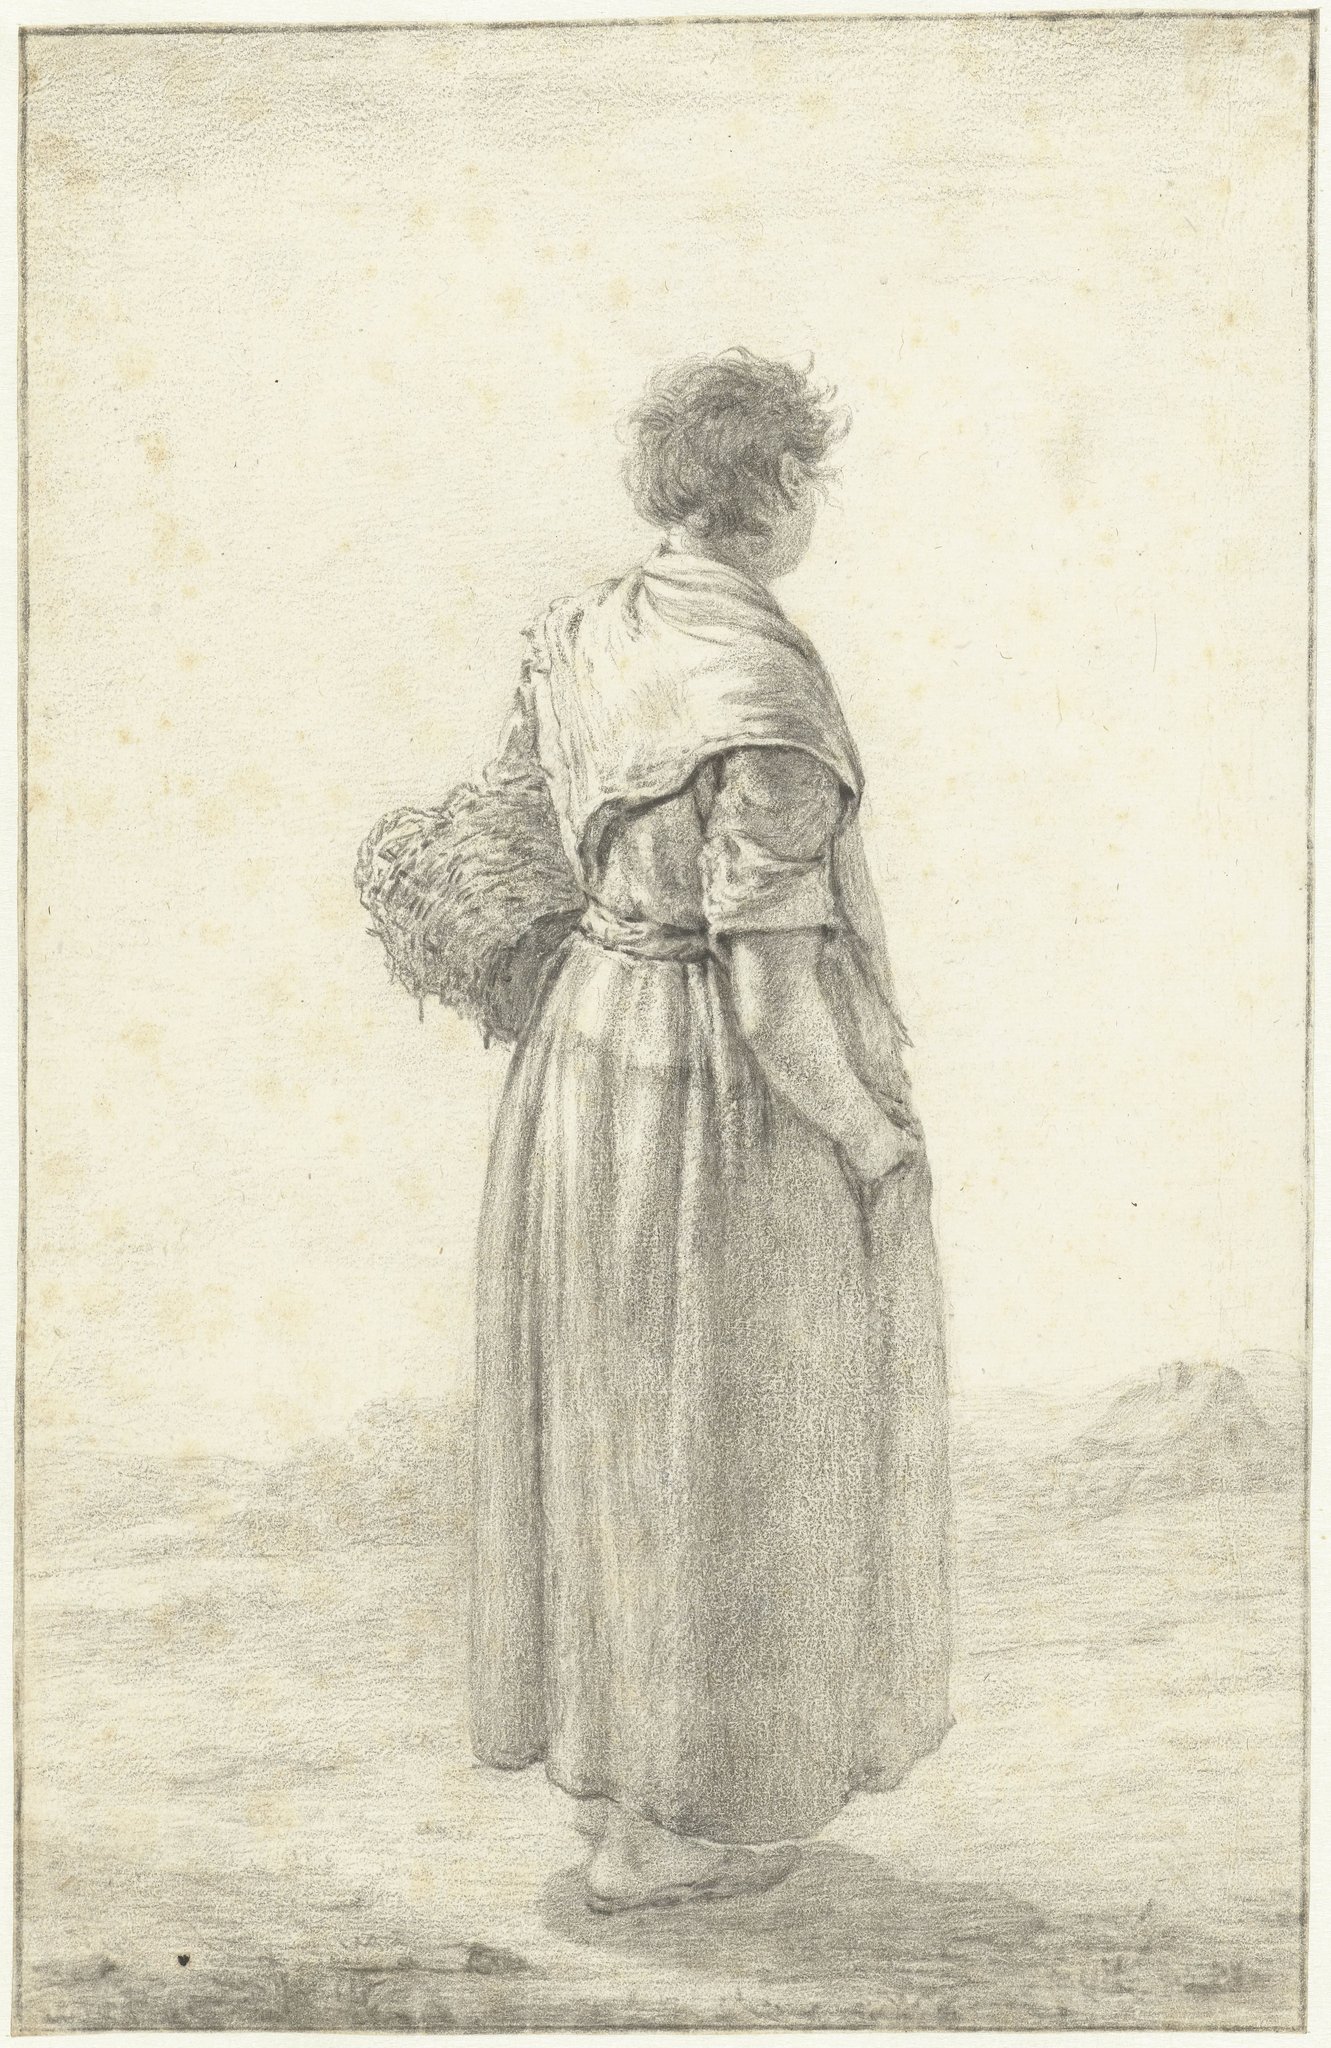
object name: drawing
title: Staande vrouw met een mand onder de arm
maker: willem albertus haanebrink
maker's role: draughtsman, print maker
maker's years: 1762-1840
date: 1772-1840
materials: chalk, paper, pencil